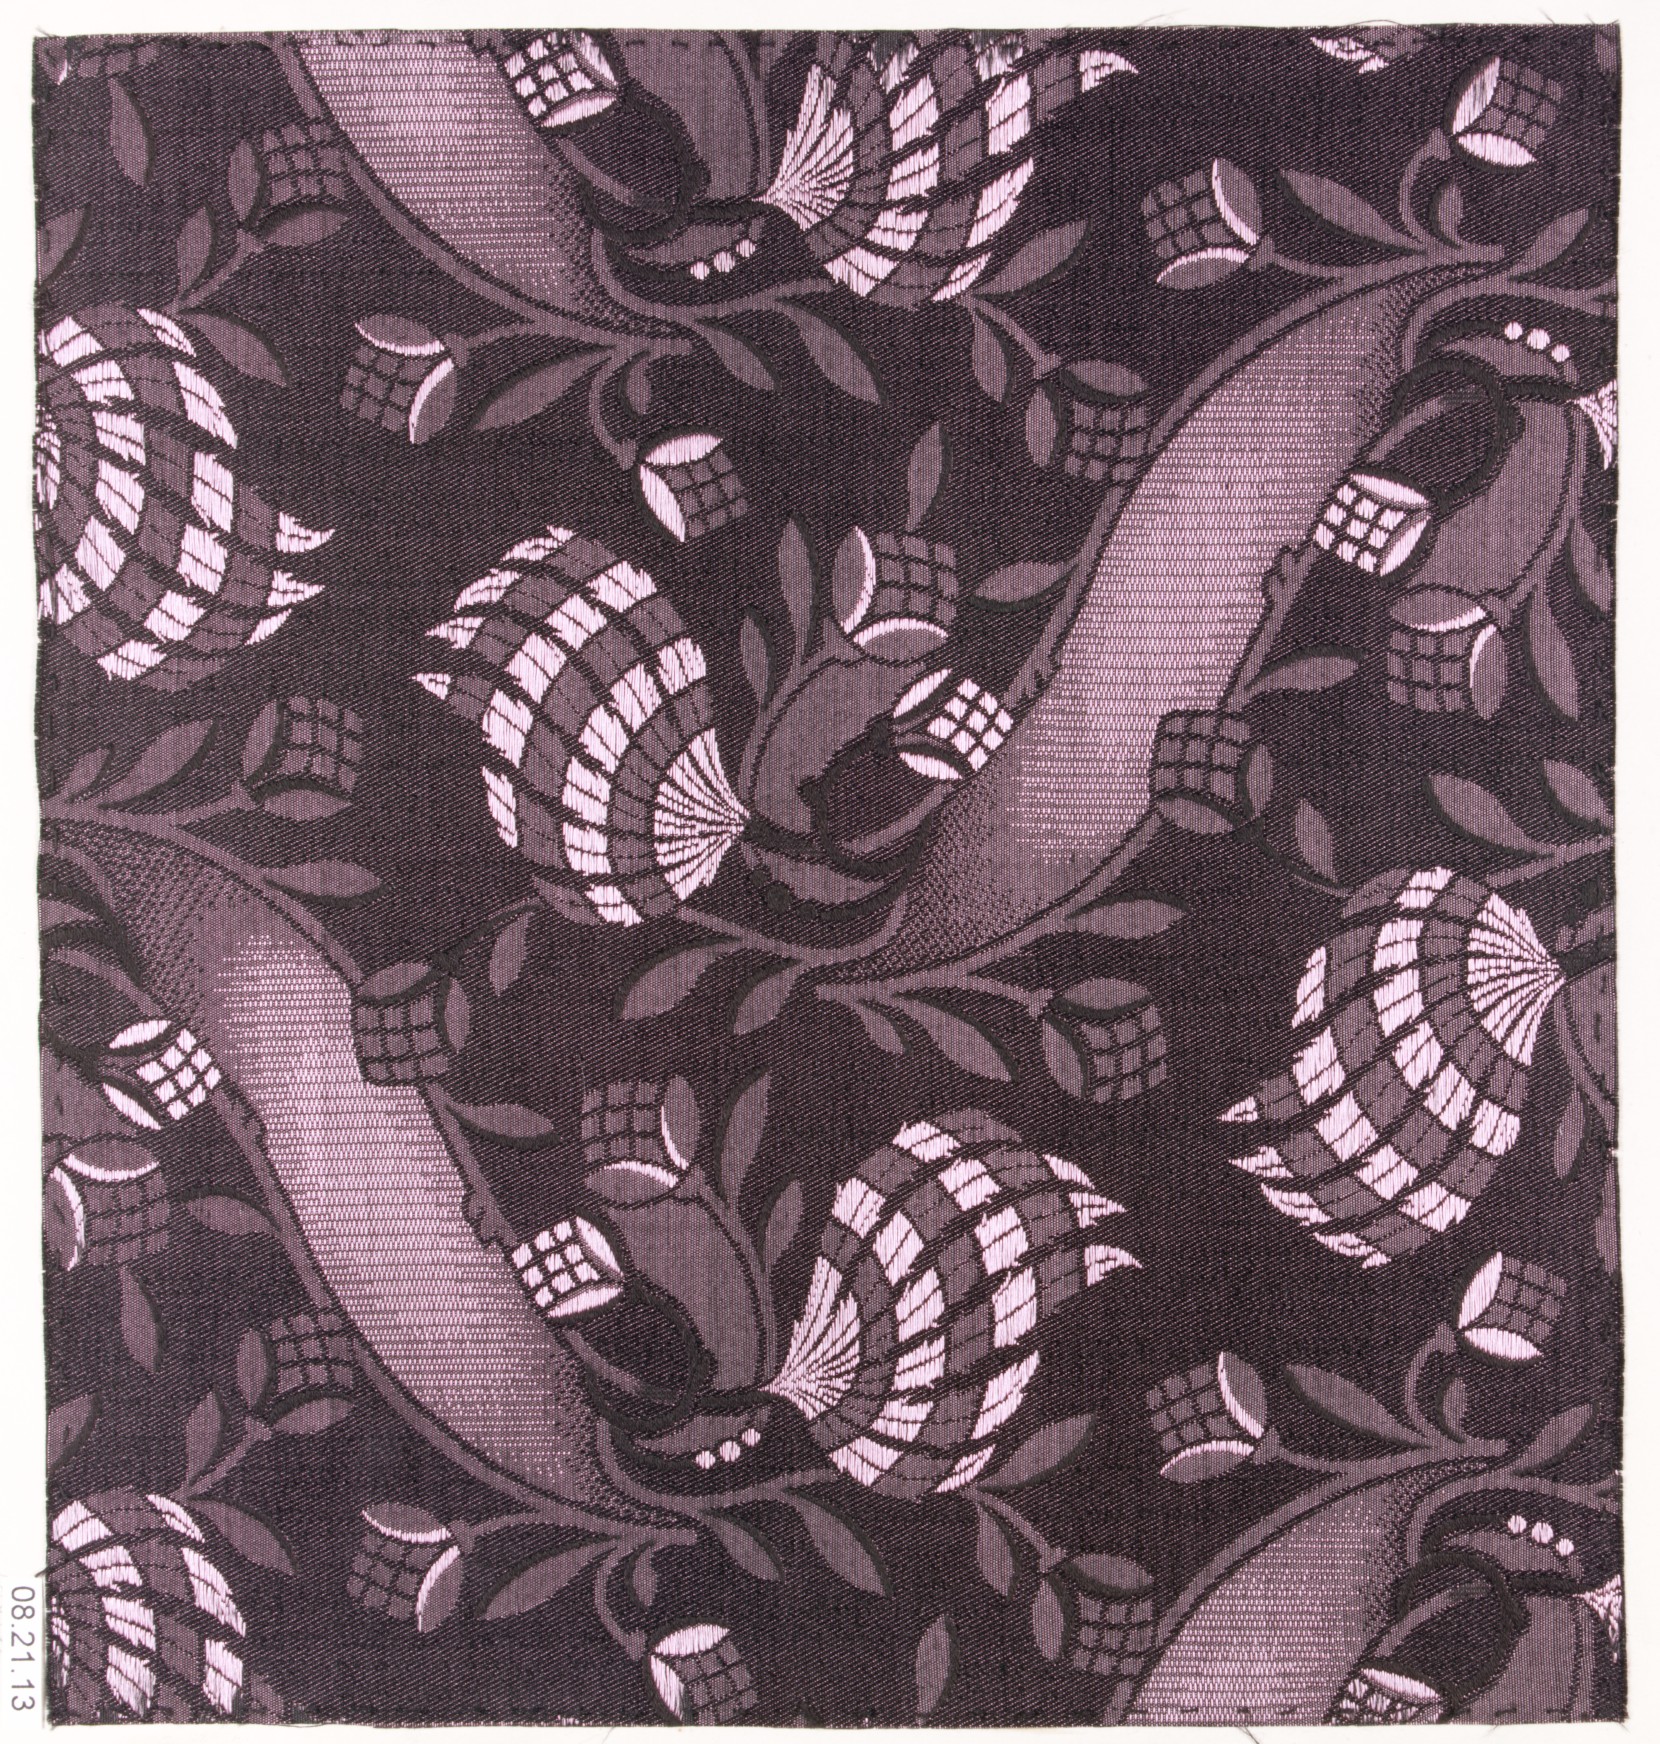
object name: textile sample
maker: Anonymous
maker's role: designer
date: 1900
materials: silk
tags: flowers